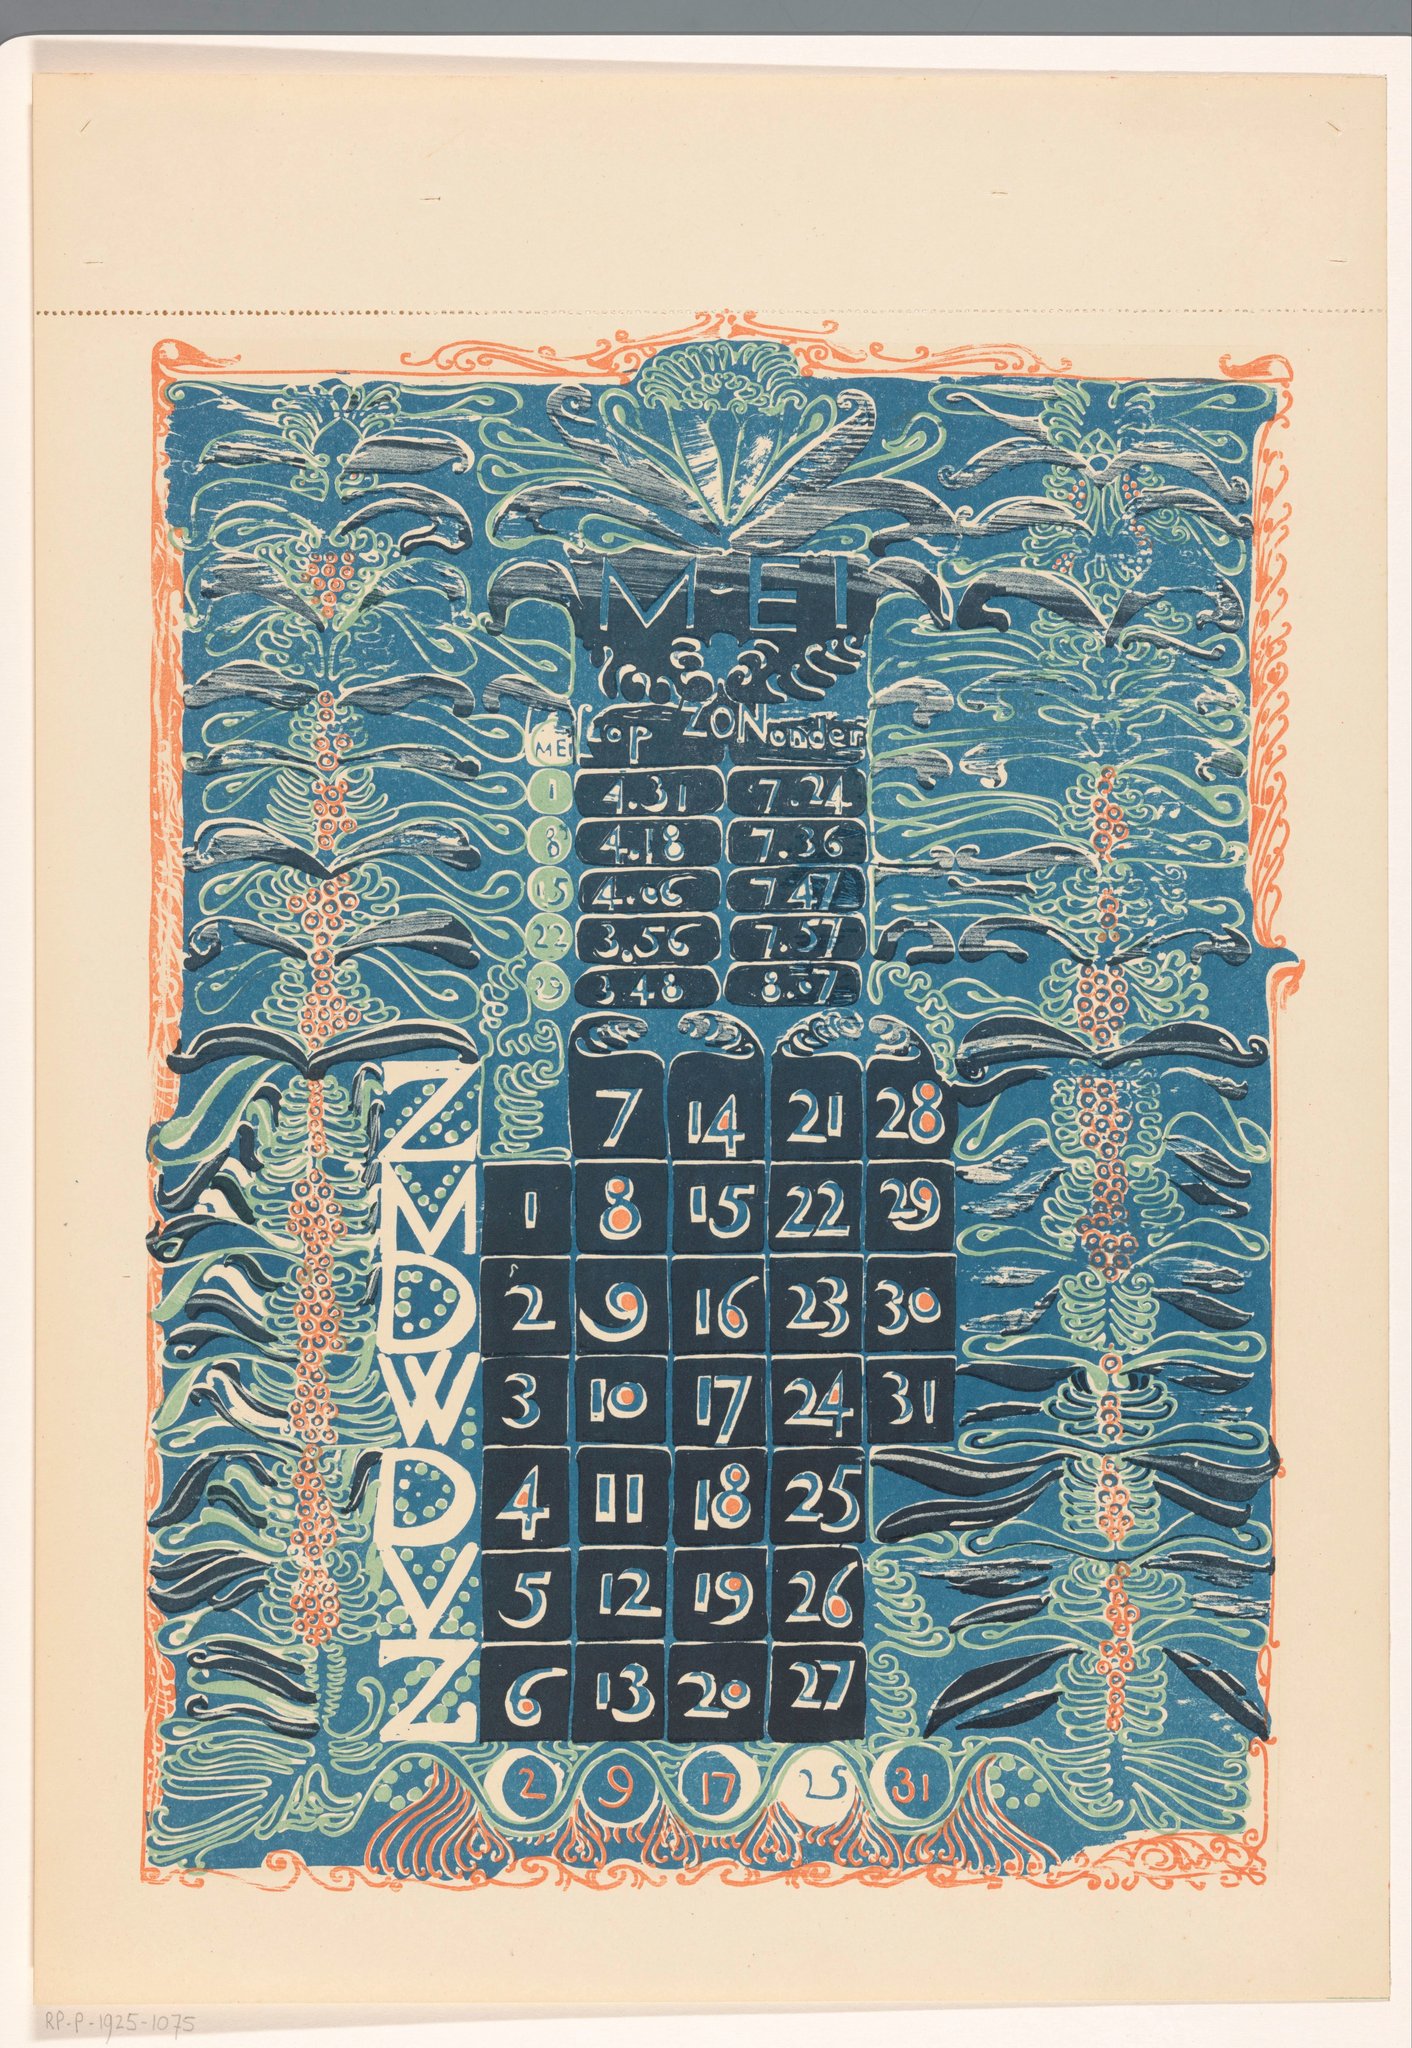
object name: calendar leaf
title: Kalenderblad mei 1899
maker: carel adolph lion cachet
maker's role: draughtsman, print maker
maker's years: 1864-1945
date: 1899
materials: paper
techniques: lithograph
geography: amsterdam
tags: may ~ other concepts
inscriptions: collector's mark: Lugt 2228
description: In 1898 vervaardigden Gerrit Willem Dijsselhof, Carel Adolph Lion Cachet en Theo Nieuwenhuis samen een kalender voor het jaar 1899. Lion Cachet nam het ontwerp van de maanden februari, mei, augustus en november op zich.